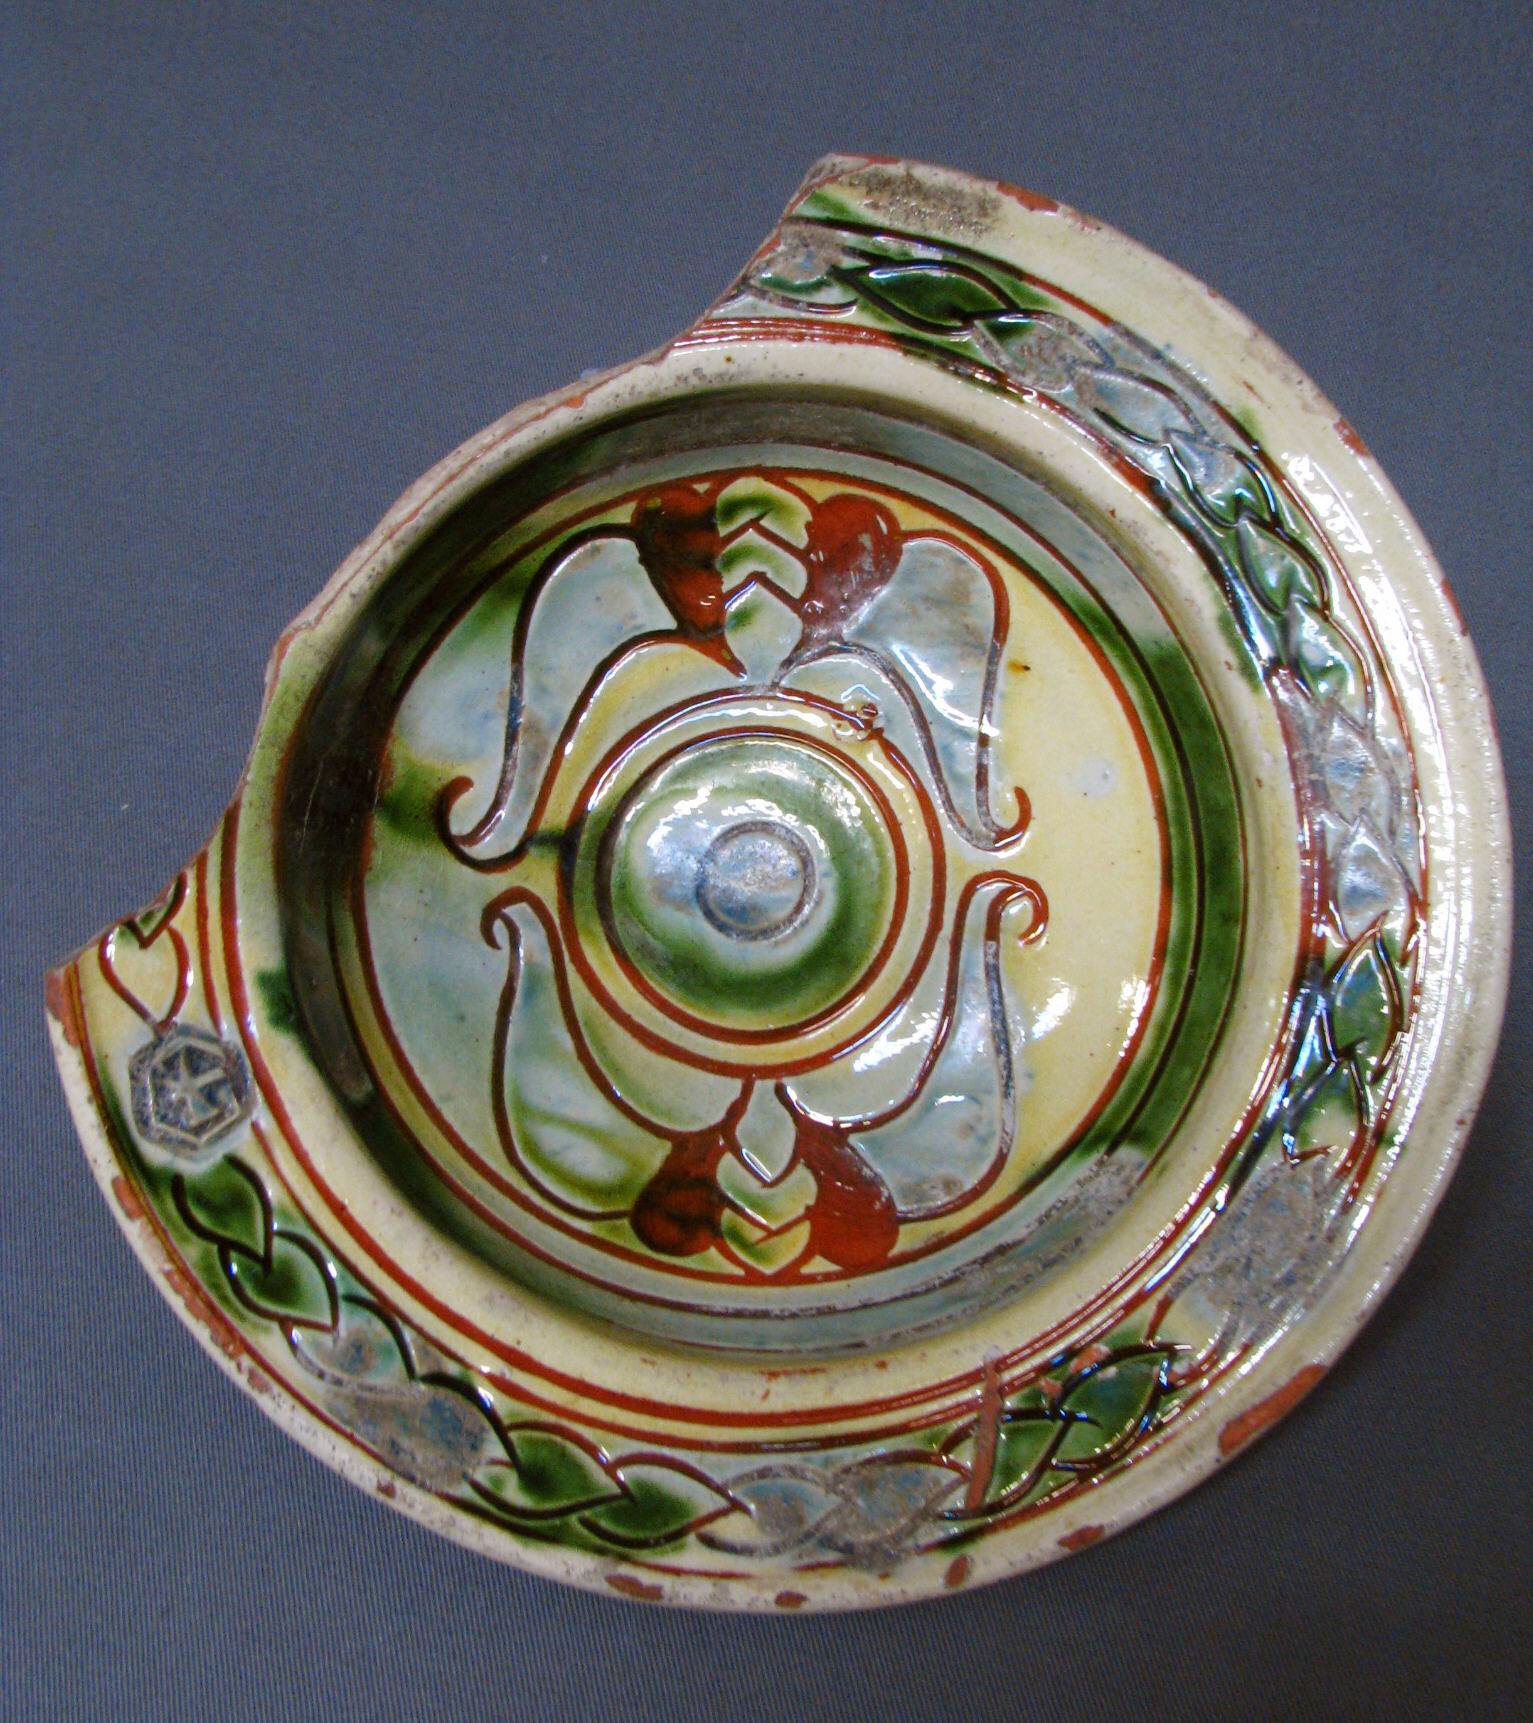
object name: dish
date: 1501-1600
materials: earthenware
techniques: glazing